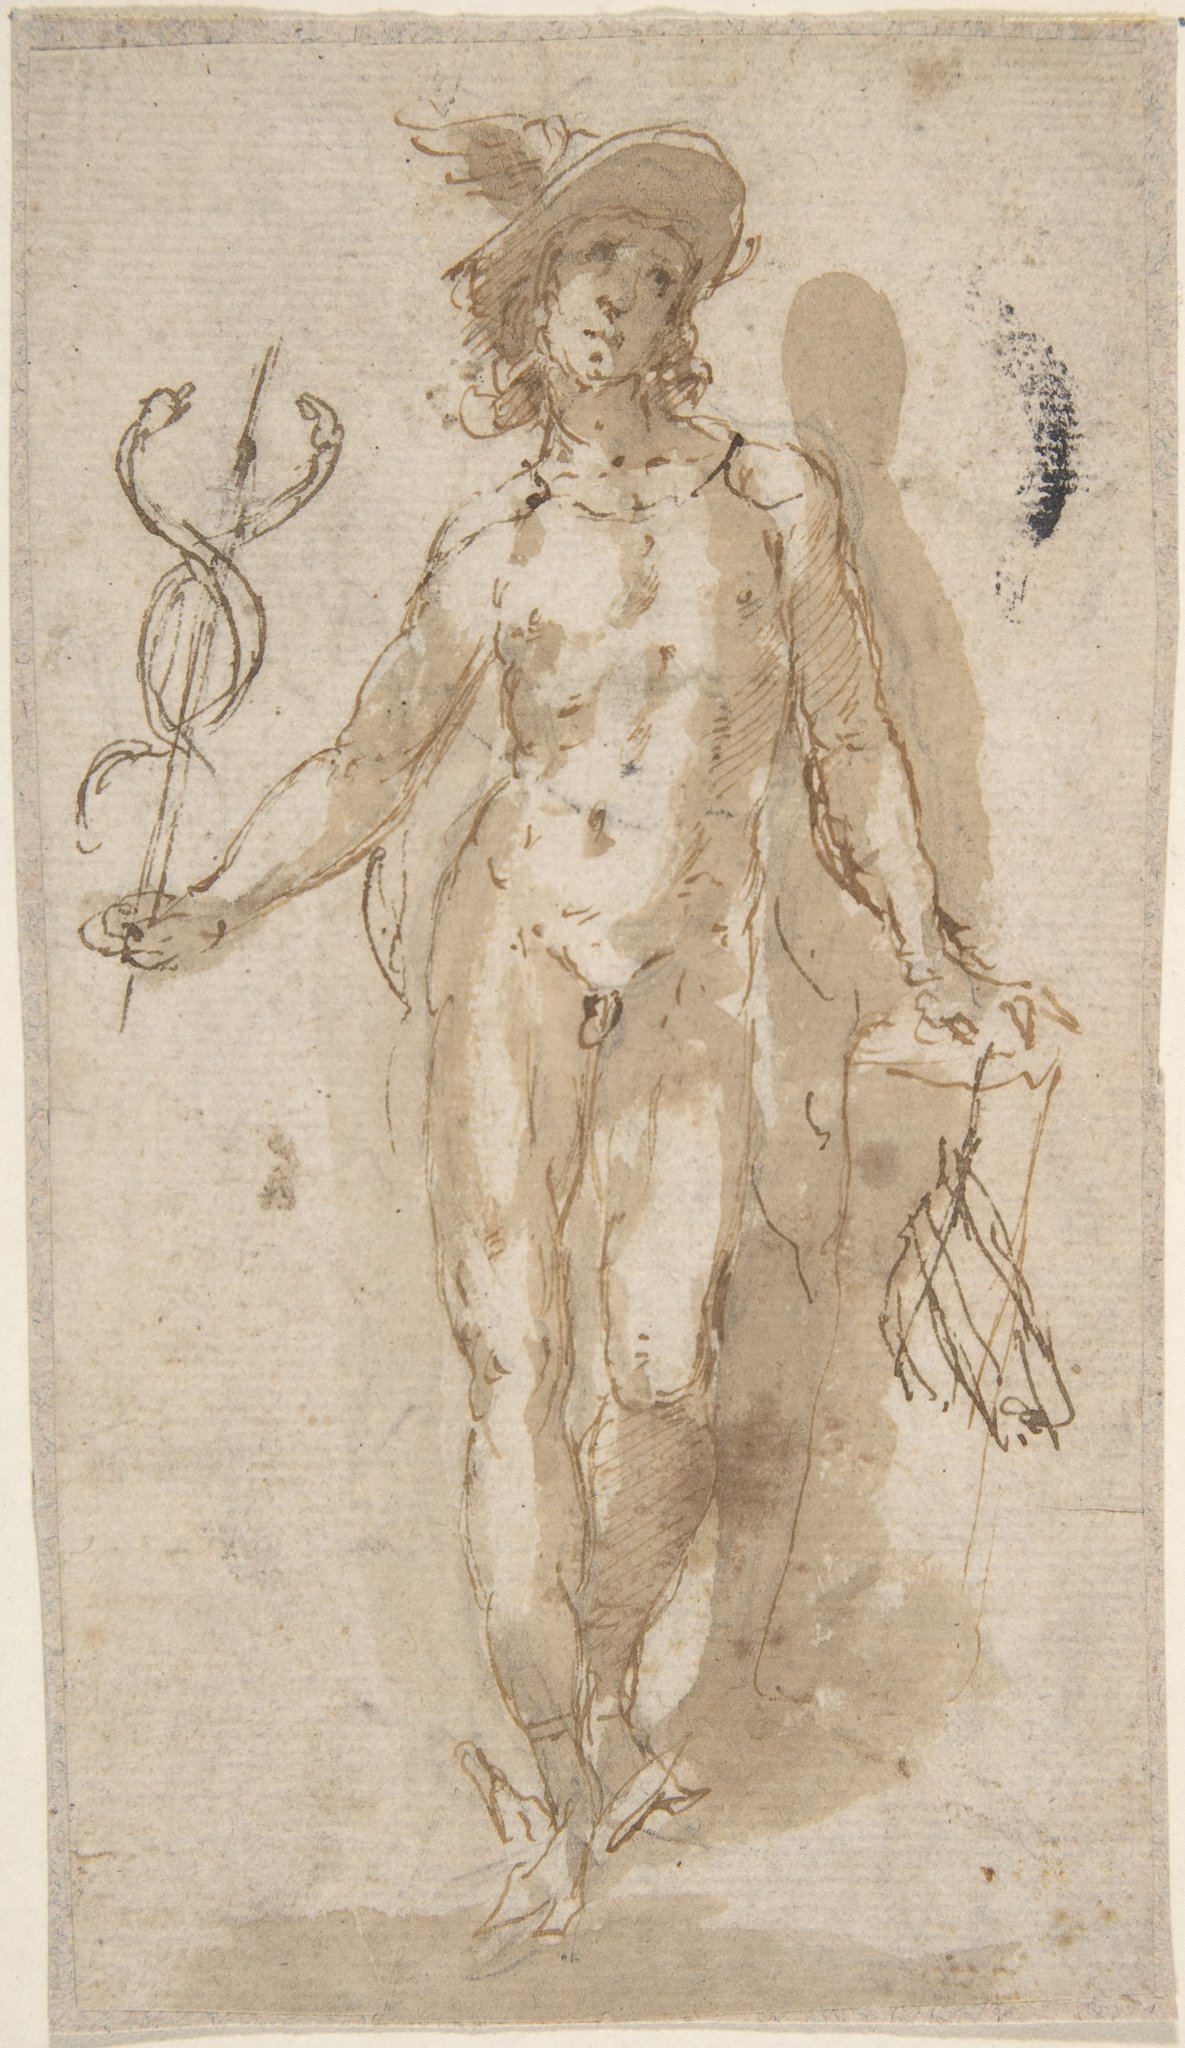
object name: drawing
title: Standing Figure of Mercury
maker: anonymous, spanish, school of seville, 17th century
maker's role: artist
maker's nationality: spanish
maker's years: 1600-1700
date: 1601-1700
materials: chalk, ink, paper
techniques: brush, pen, drawing, wash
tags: mercury